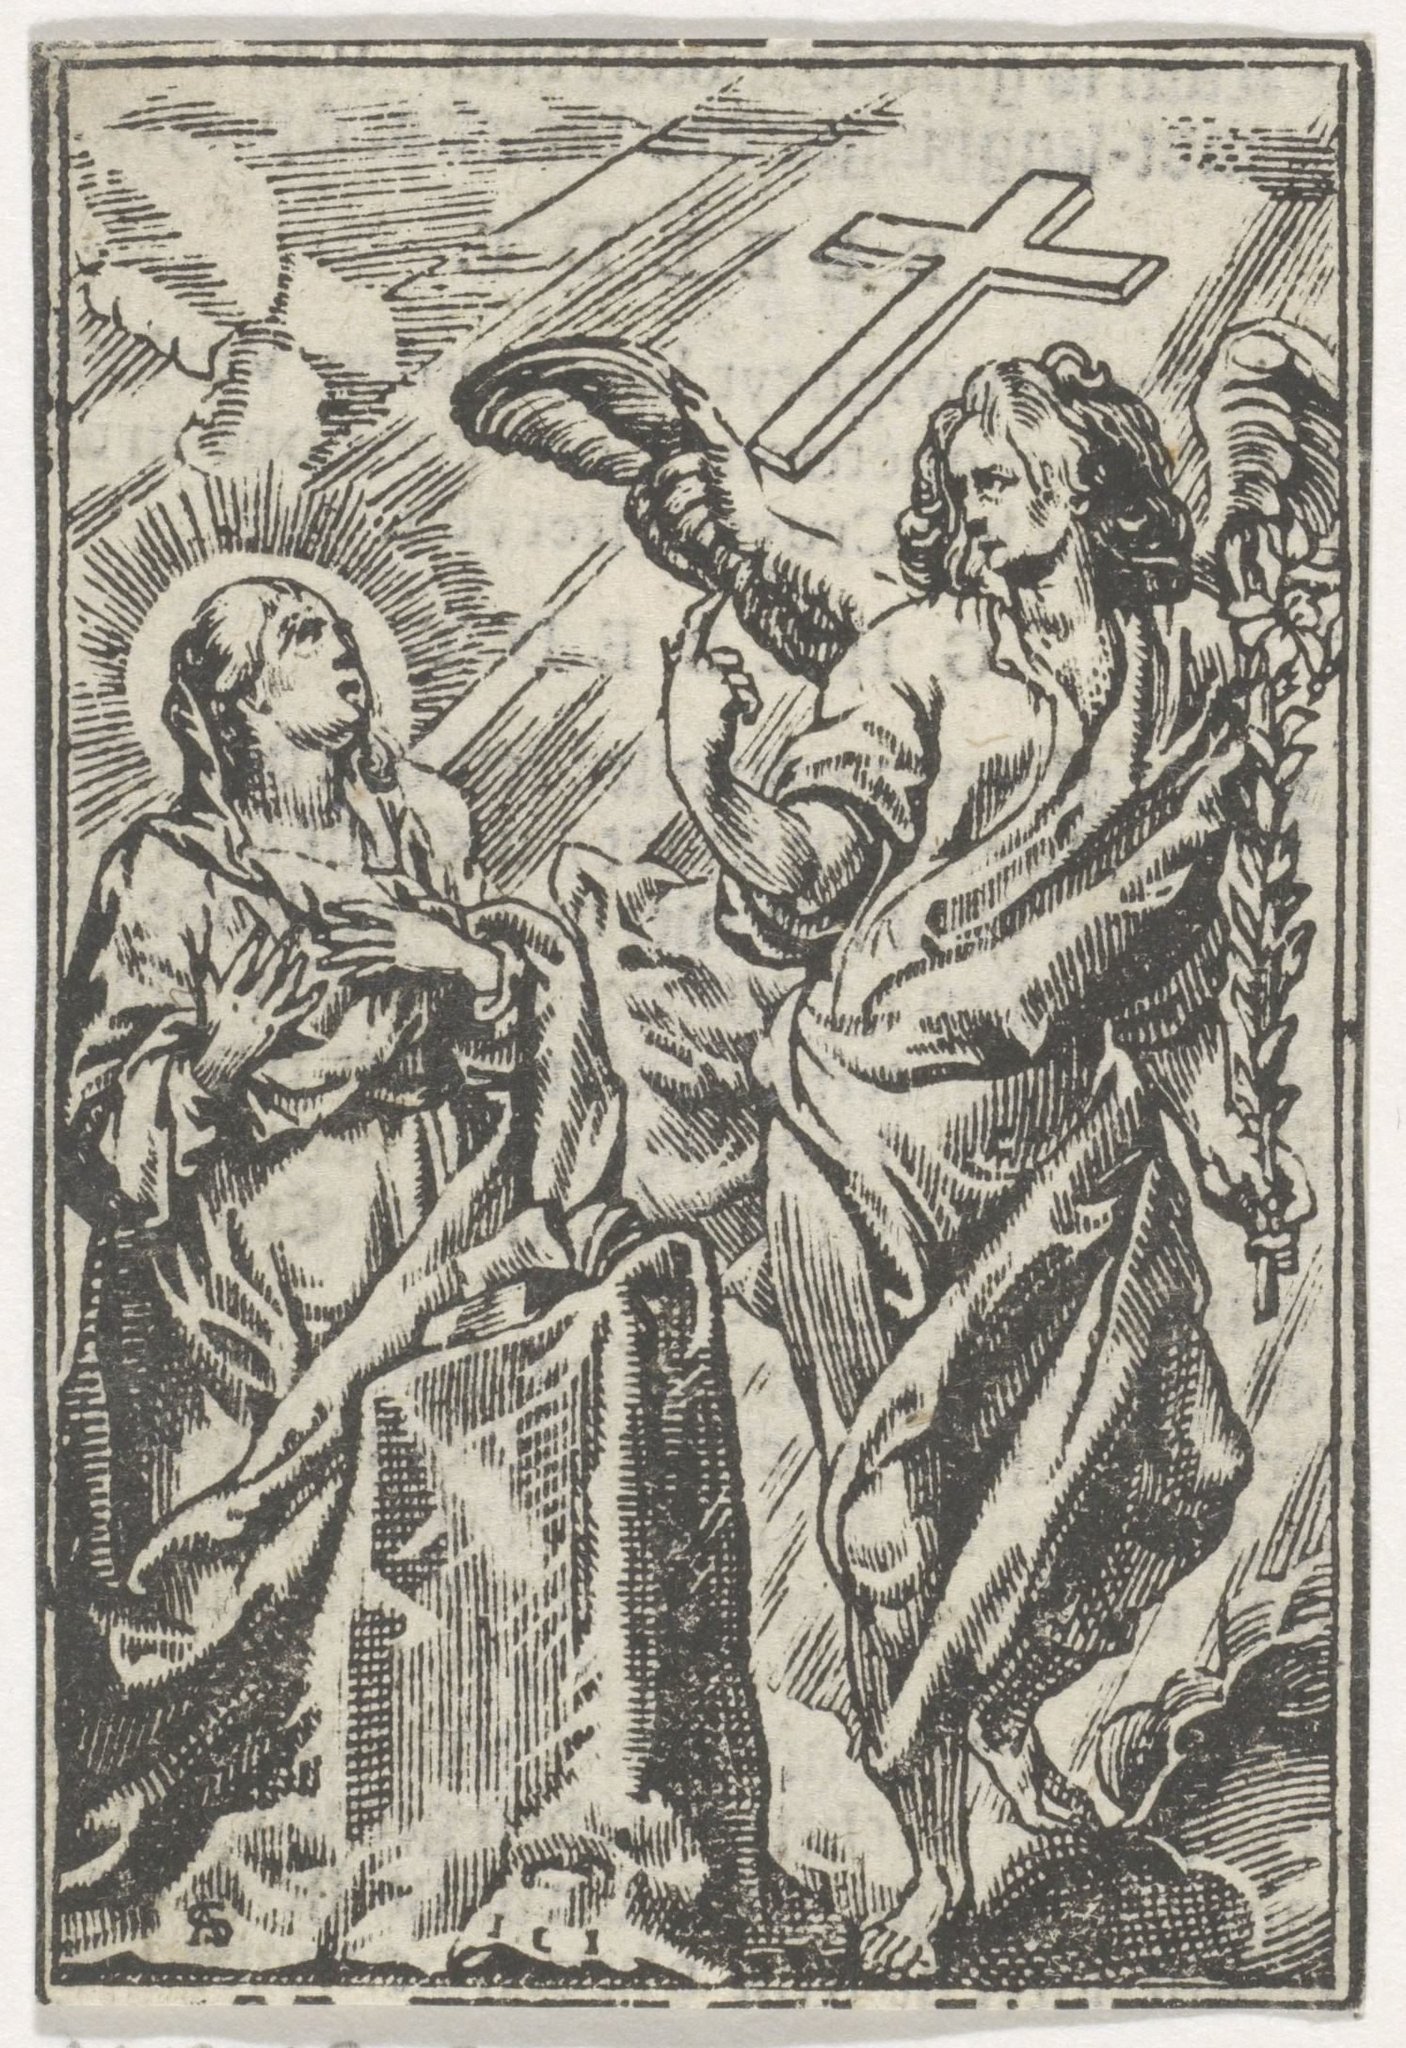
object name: book illustration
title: Annunciatie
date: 1649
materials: paper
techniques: letterpress printing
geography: antwerp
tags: the annunciation: mary, usually reading, is visited by the angel (sometimes a woman overhears the conversation)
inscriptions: collector's mark: Lugt 2228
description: De engel Gabriël kondigt aan Maria aan dat ze zwanger zal worden. Maria zit geknield bij een lessenaar, waarop een opengeslagen boek ligt.